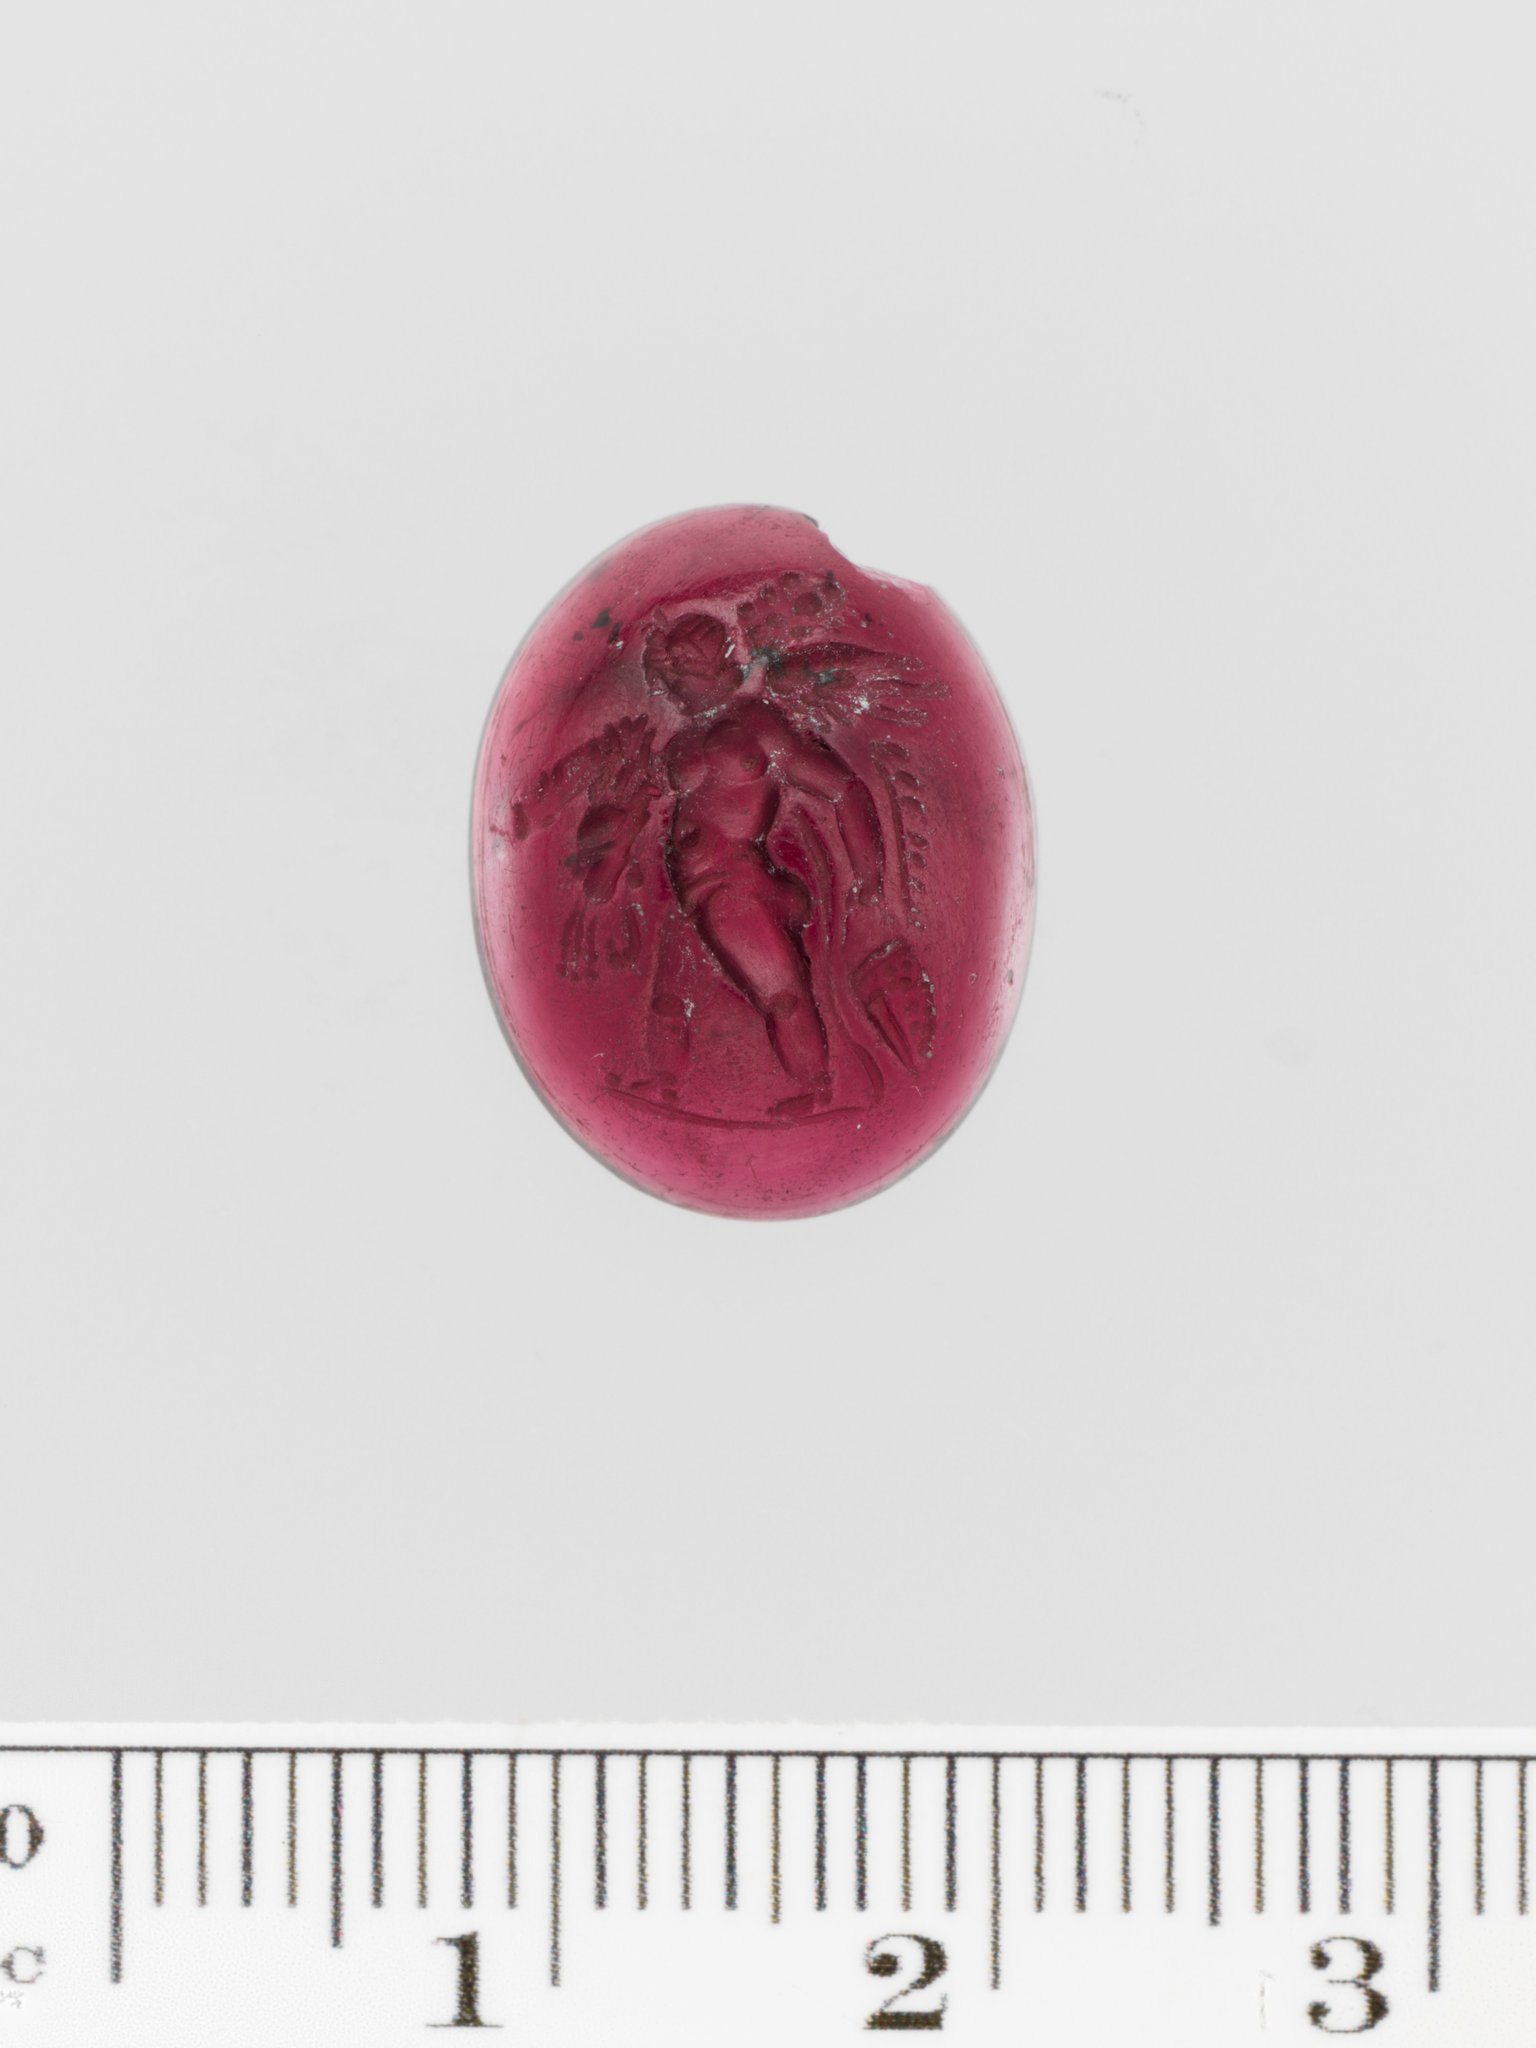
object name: intaglio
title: Garnet ring stone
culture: italic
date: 100-1 BCE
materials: gemstone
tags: eros